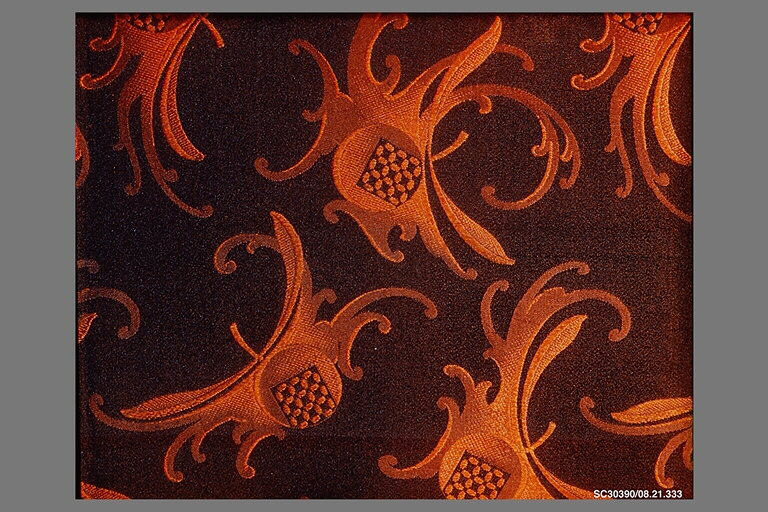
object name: textile sample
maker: Anonymous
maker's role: designer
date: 1900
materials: silk